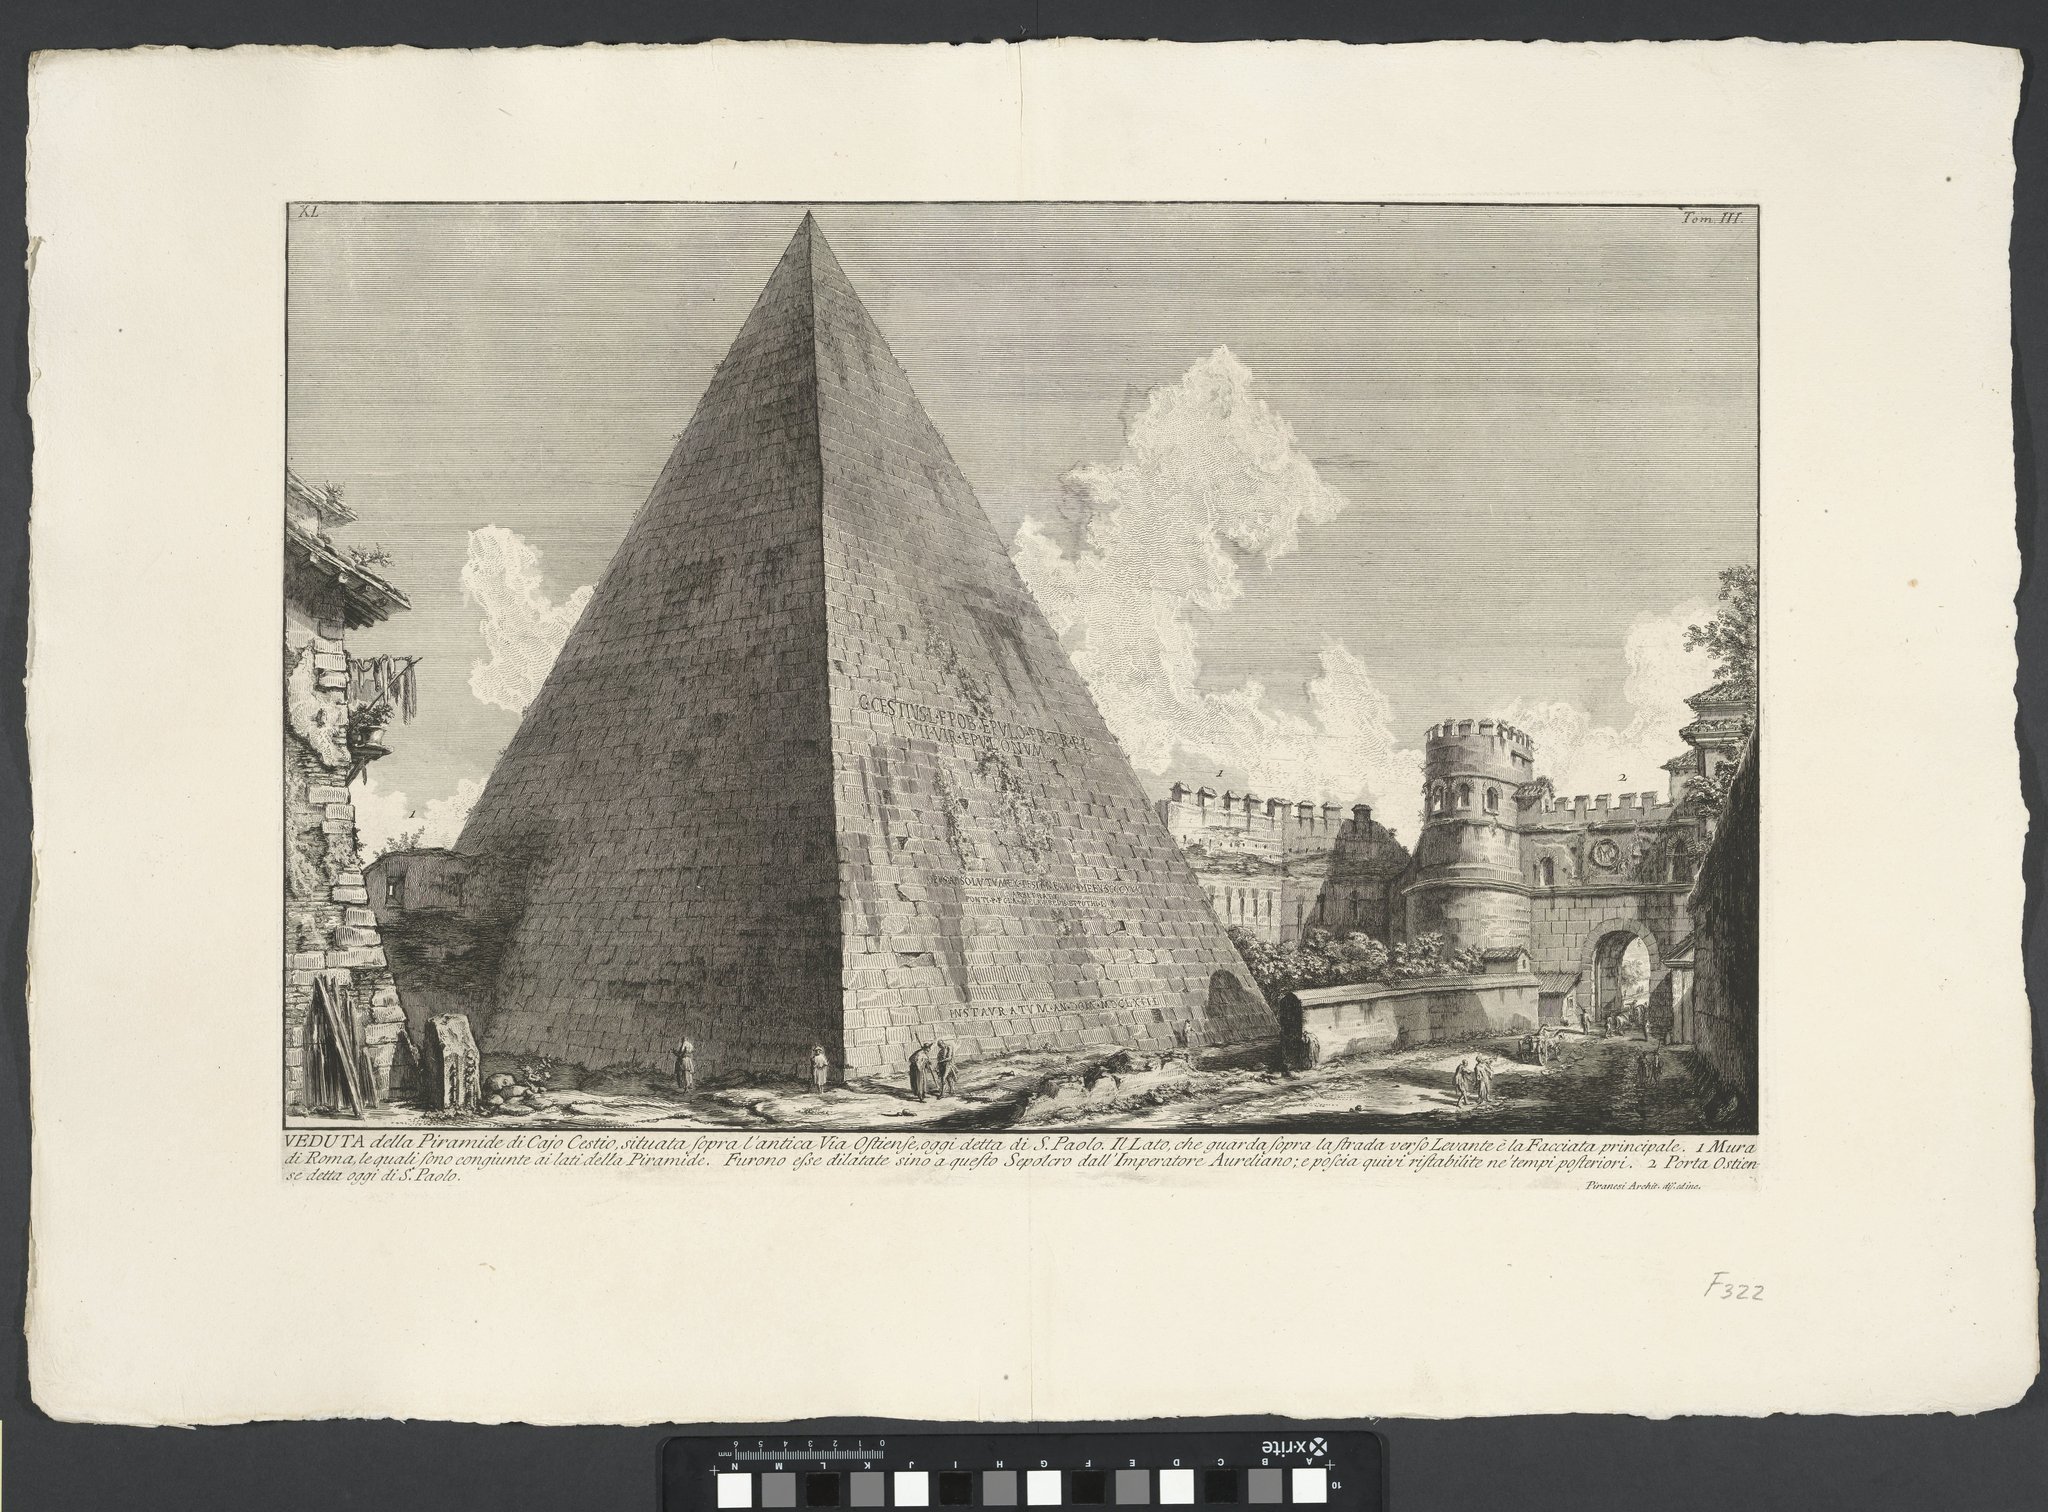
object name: print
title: Veduta della Piramide di Caio Cestio, situata sopra l'antica Via Ostiense, oggi detta di S. Paolo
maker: giovanni battista piranesi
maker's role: designer, draughtsman, print maker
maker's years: 1720-1778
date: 1756-1757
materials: paper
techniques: etching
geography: rome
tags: city-view, and landscape with man-made constructions, pyramid (marking grave), rome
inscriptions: collector's mark: Lugt 2228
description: Deze prent maakt deel uit van de serie 'Le Antichità Romane'. Piranesi deed meer dan acht jaar voorstudie voor deze 250 platen tellende serie die in vier volumes werd uitgegeven. Hij produceerde de prenten tussen ca. 1756 en 1757. De serie bevat ook prenten door of naar andere prentmakers, onder wie Francesco Bianchini en Girolamo Rossi.